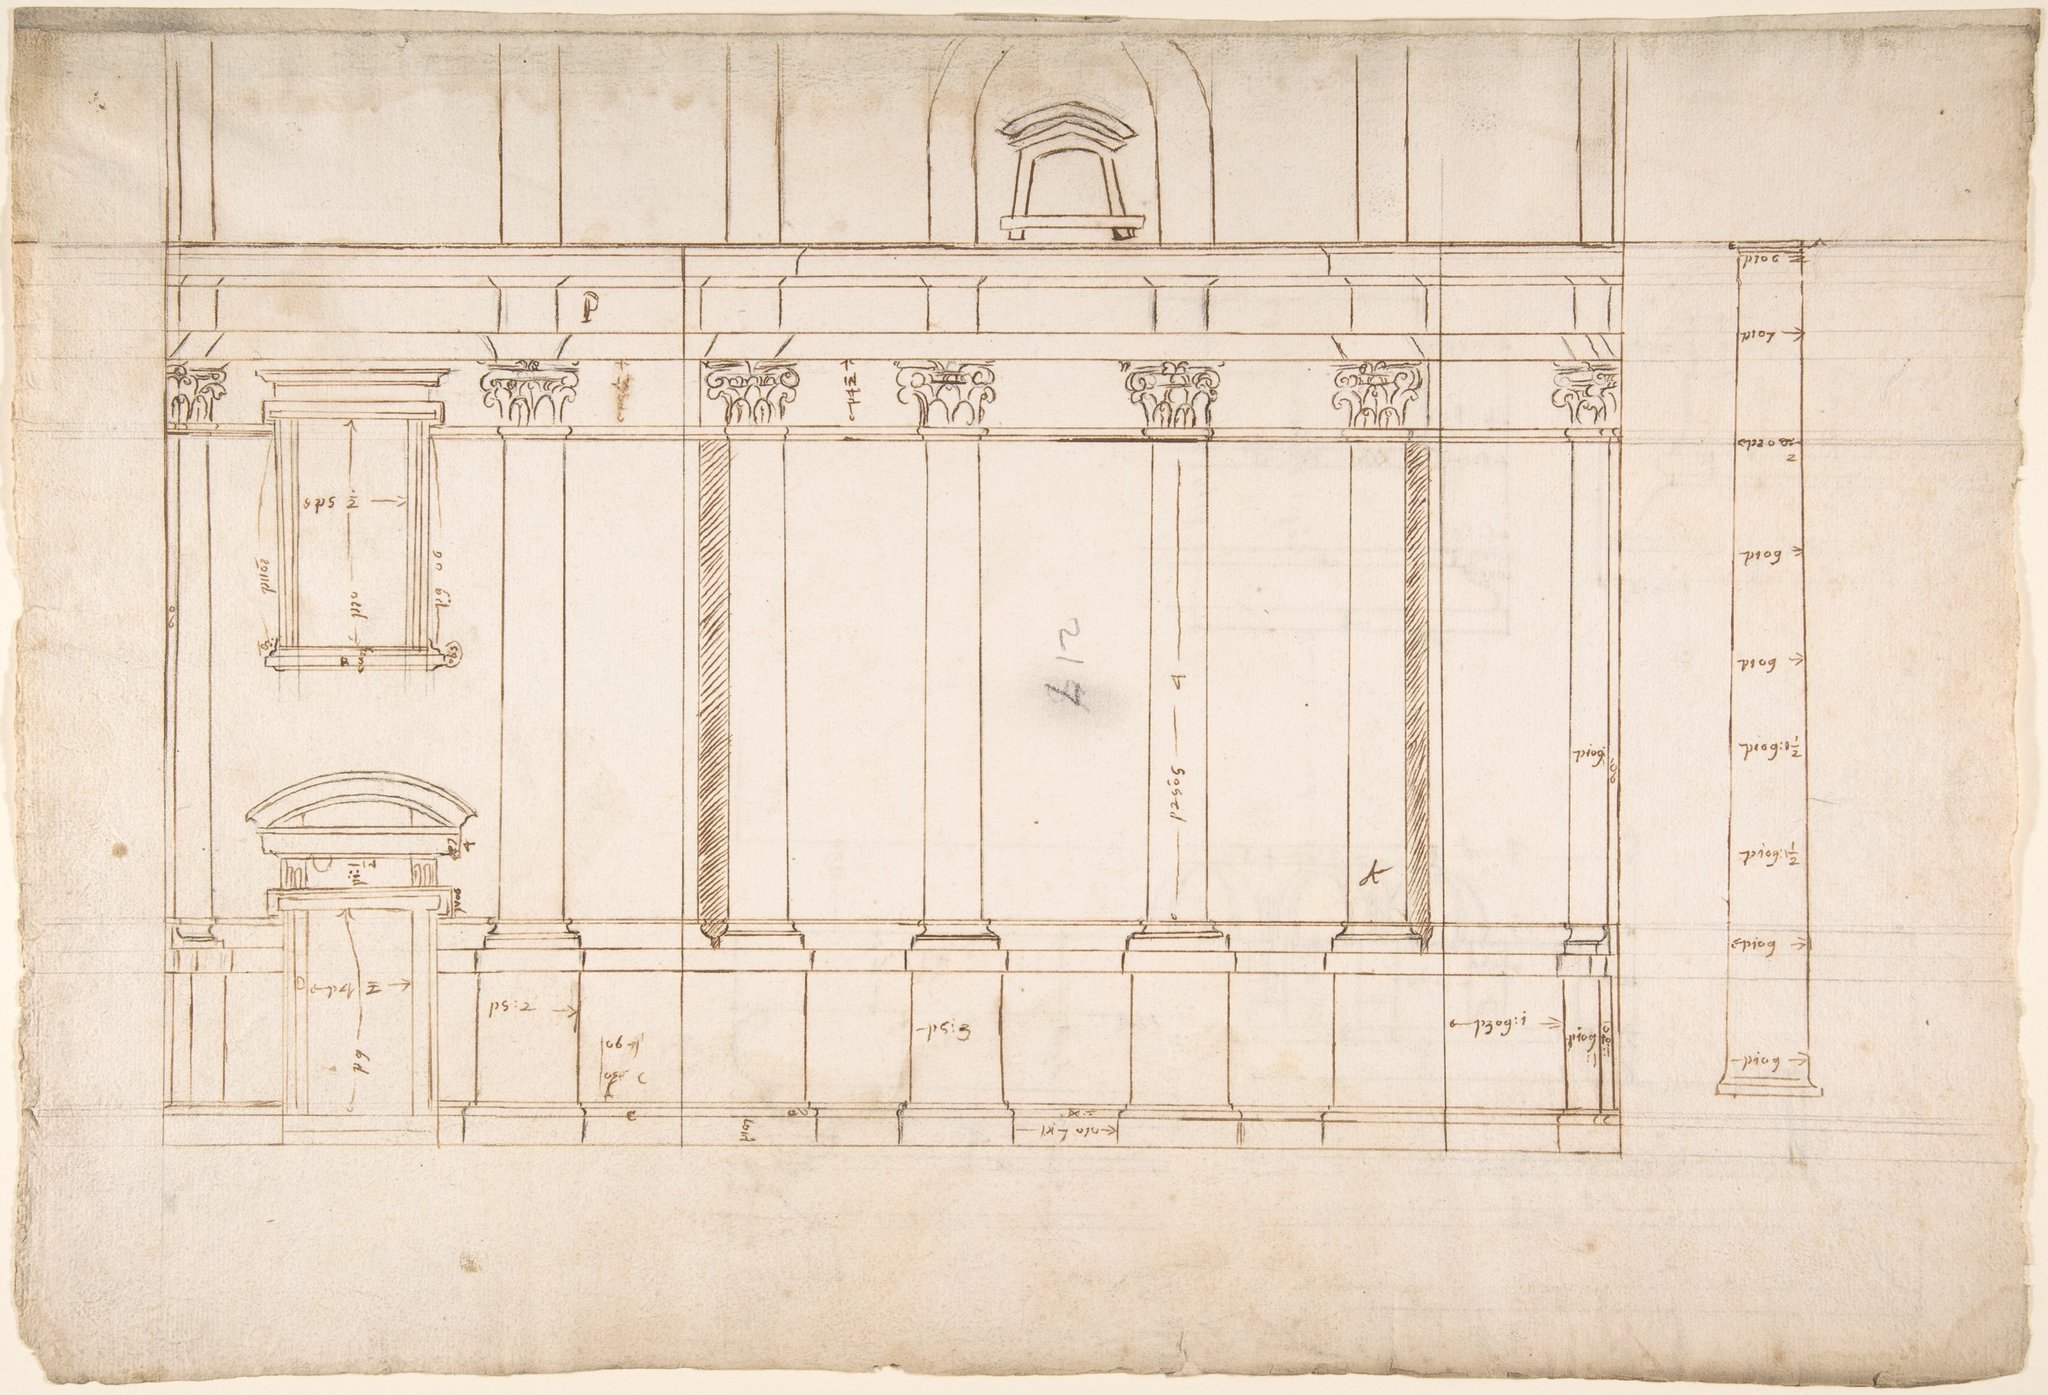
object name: drawing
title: Santa Maria Maggiore, Sforza Chapel, elevation (recto) Unknown, entablature, partial cornice, and column or pilaster base profile (verso)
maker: anonymous, french, 16th century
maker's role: draftsman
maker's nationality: french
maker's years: 1500-1600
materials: chalk, ink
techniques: incising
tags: architecture